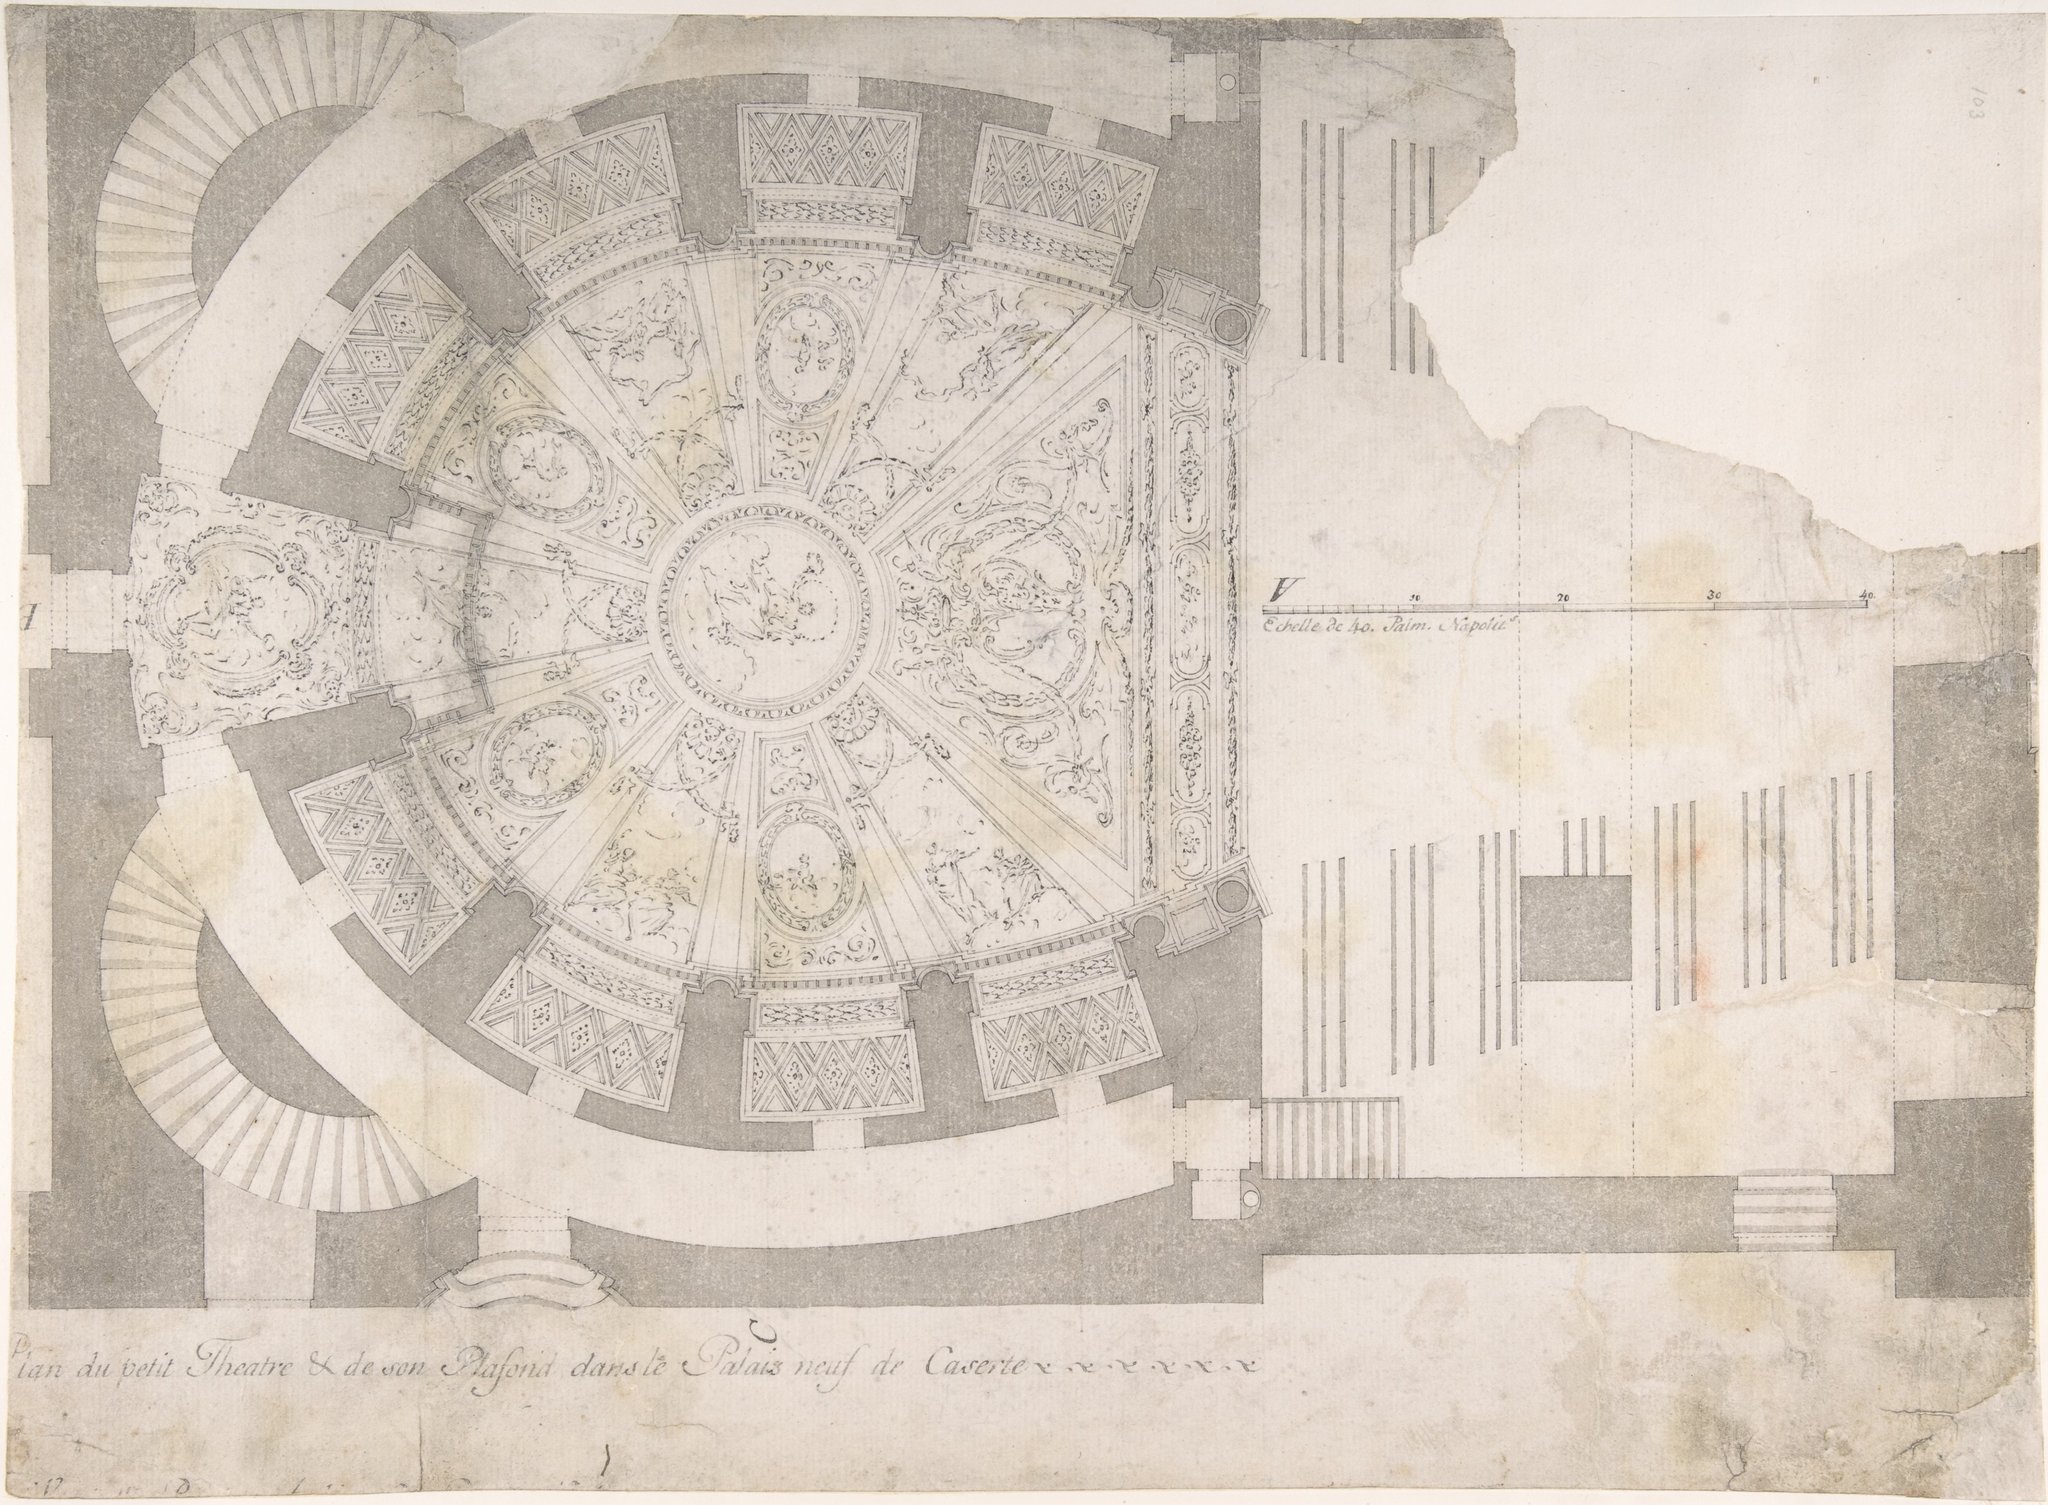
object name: drawing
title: Projection of Ceiling Over Plan of the Small Theater in the Palace at Caserta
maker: luigi vanvitelli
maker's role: artist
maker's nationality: italian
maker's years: 1700-1773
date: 1700-1773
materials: graphite, ink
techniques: brush, pen, drawing, wash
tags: architecture